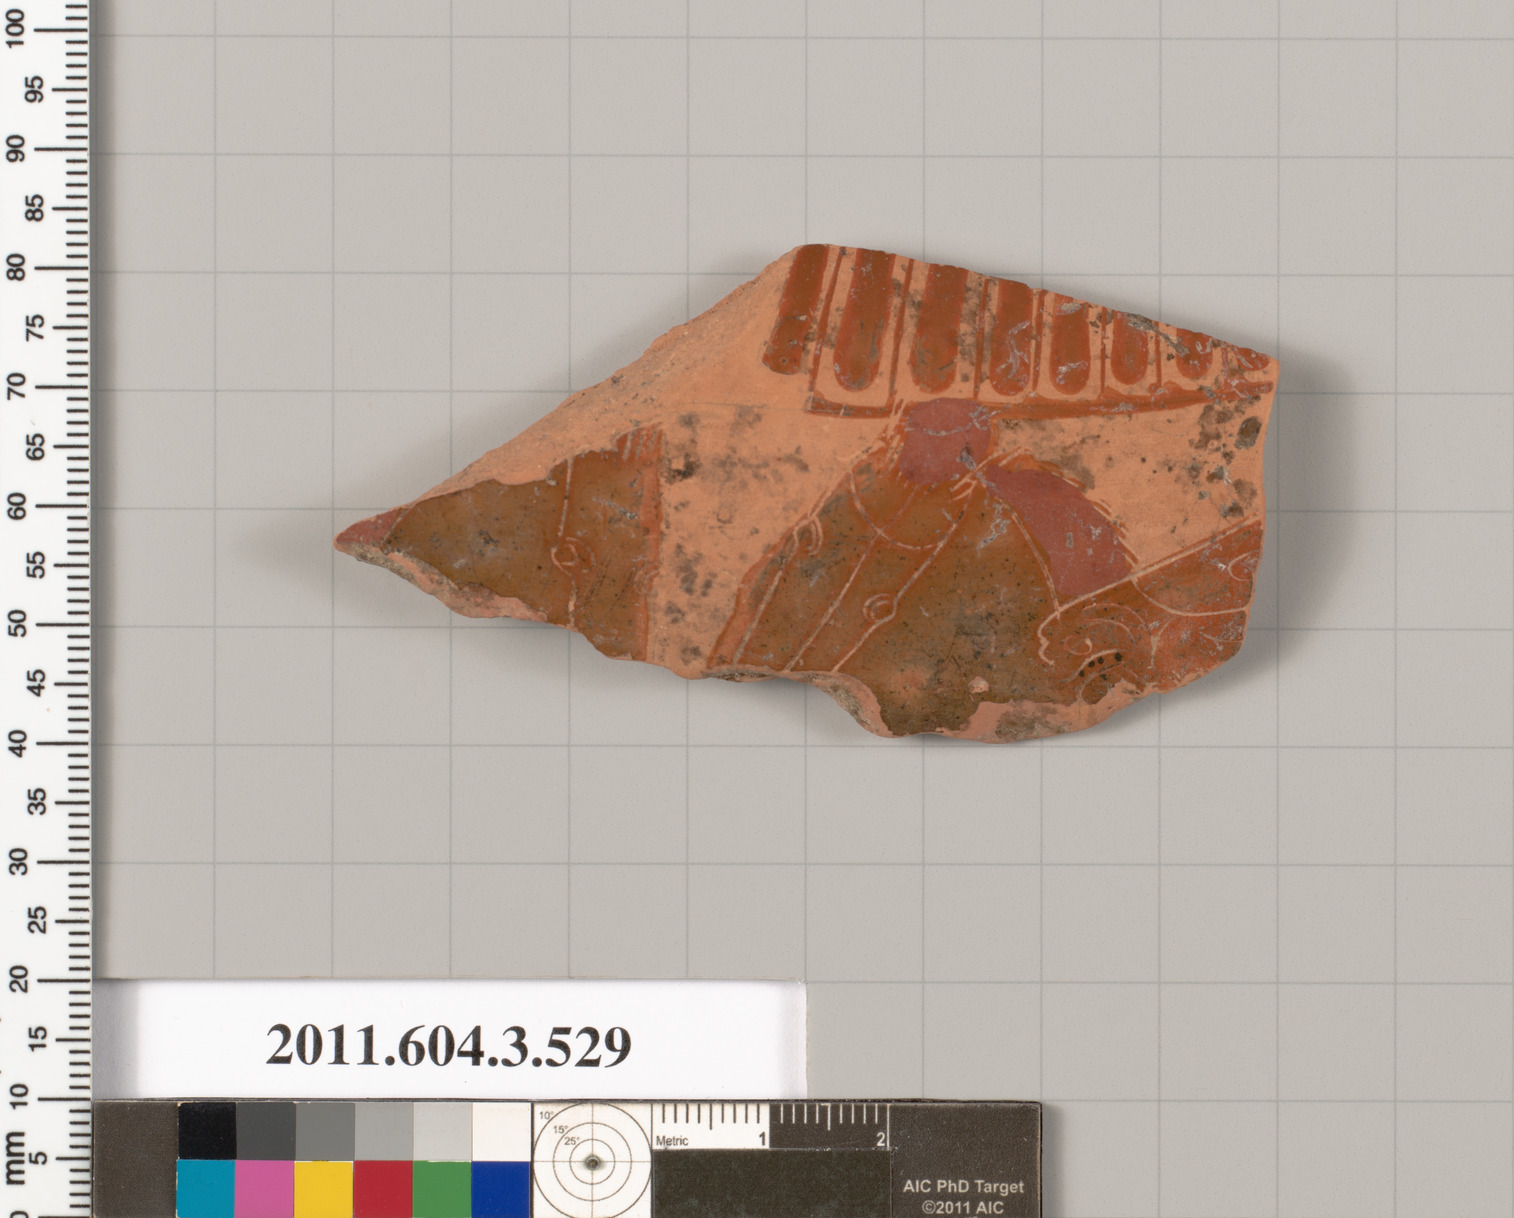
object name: column krater fragment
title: Terracotta fragment of a column-krater (bowl for mixing wine and water)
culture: greek, attic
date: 534-468 BCE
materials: terracotta